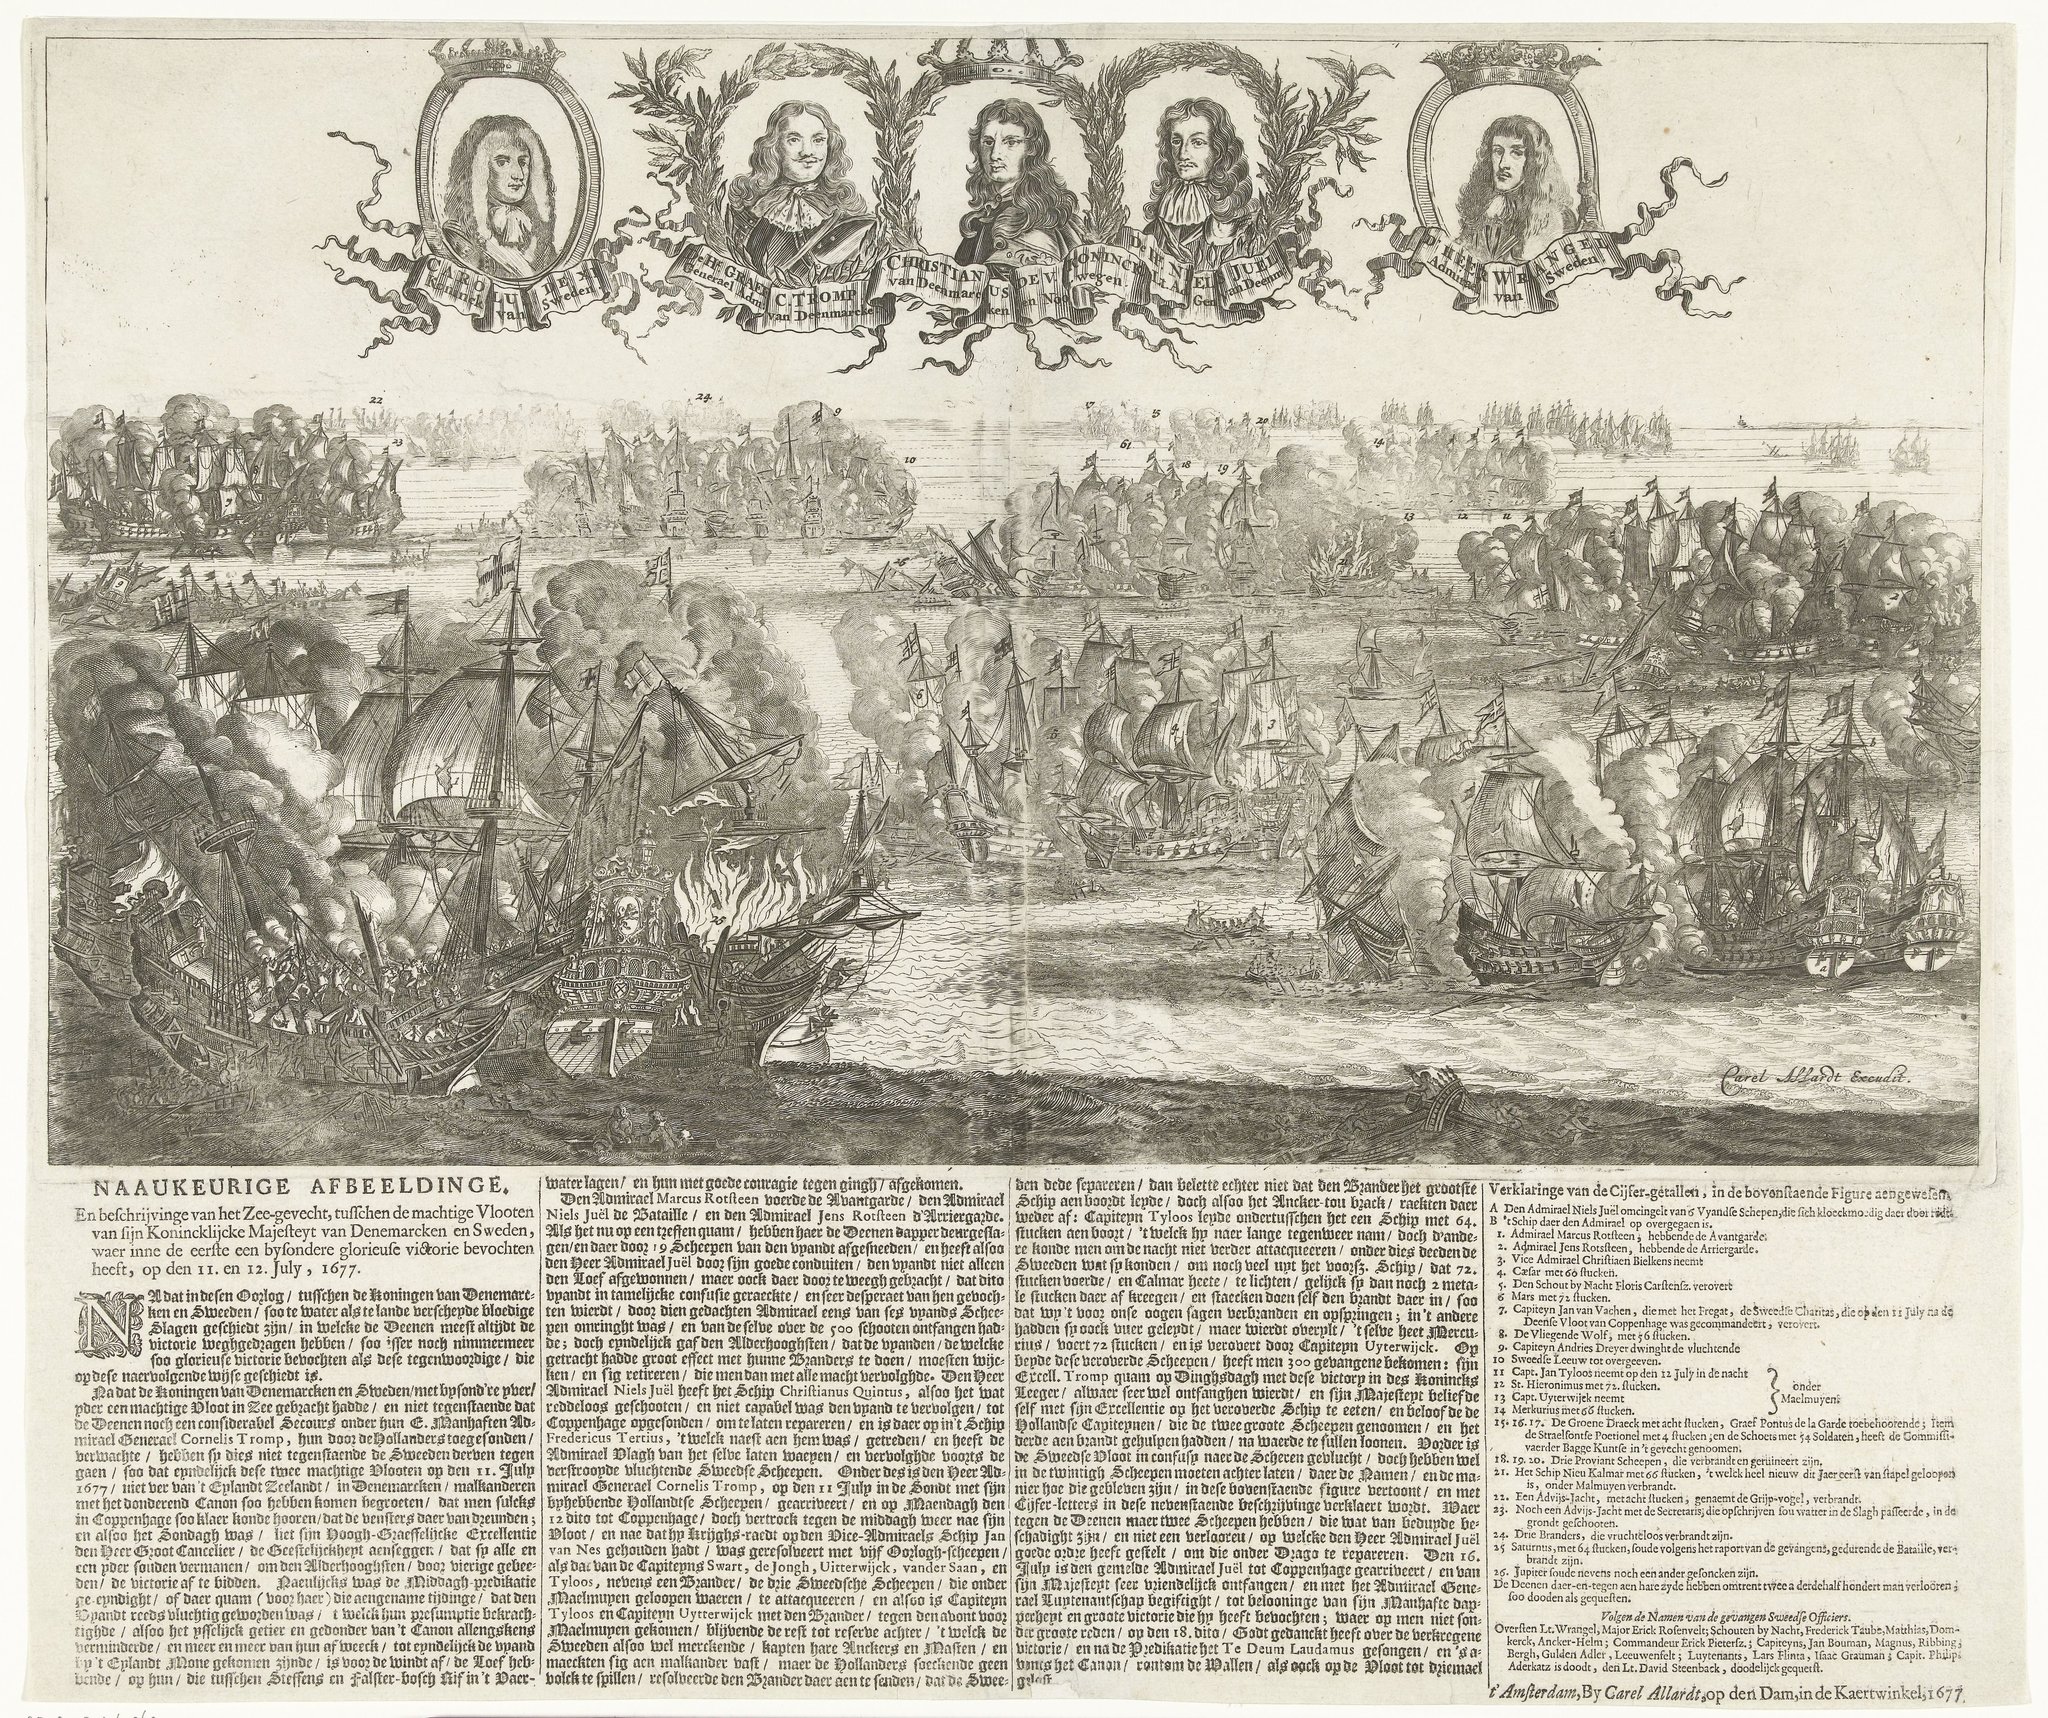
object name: print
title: Zeeslag in de Kooge Bocht, 1677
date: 1673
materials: paper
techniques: engraving, etching, letterpress printing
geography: northern netherlands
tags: rotterdam, amsterdam, cornelis tromp, copenhagen (city), battle (+ naval force)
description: Zeeslag tussen een Deens-Noorse vloot en een Zweedse vloot 1-2 juli 1677, waarbij de Denen de overwinning behaalden. Op de voorgrond rechts het schip van de Deense admiraal Niels Juel, omsingeld door 6 vijandelijke schepen. Hogerop in het midden de Hollandse schepen van Tyloos, Uiterwijk etc. Links op de voorgrond een Zweeds schip in brand. Boven het tafereel de portretten van Karel XI van Zweden, Christiaan V van Denemarken en de admiralen Niels Juël, Wrangel en Cornelis Tromp. Met een tekst gedrukt op het blad onder de prent van 4 kolommen met de legenda A-B en 1-26.